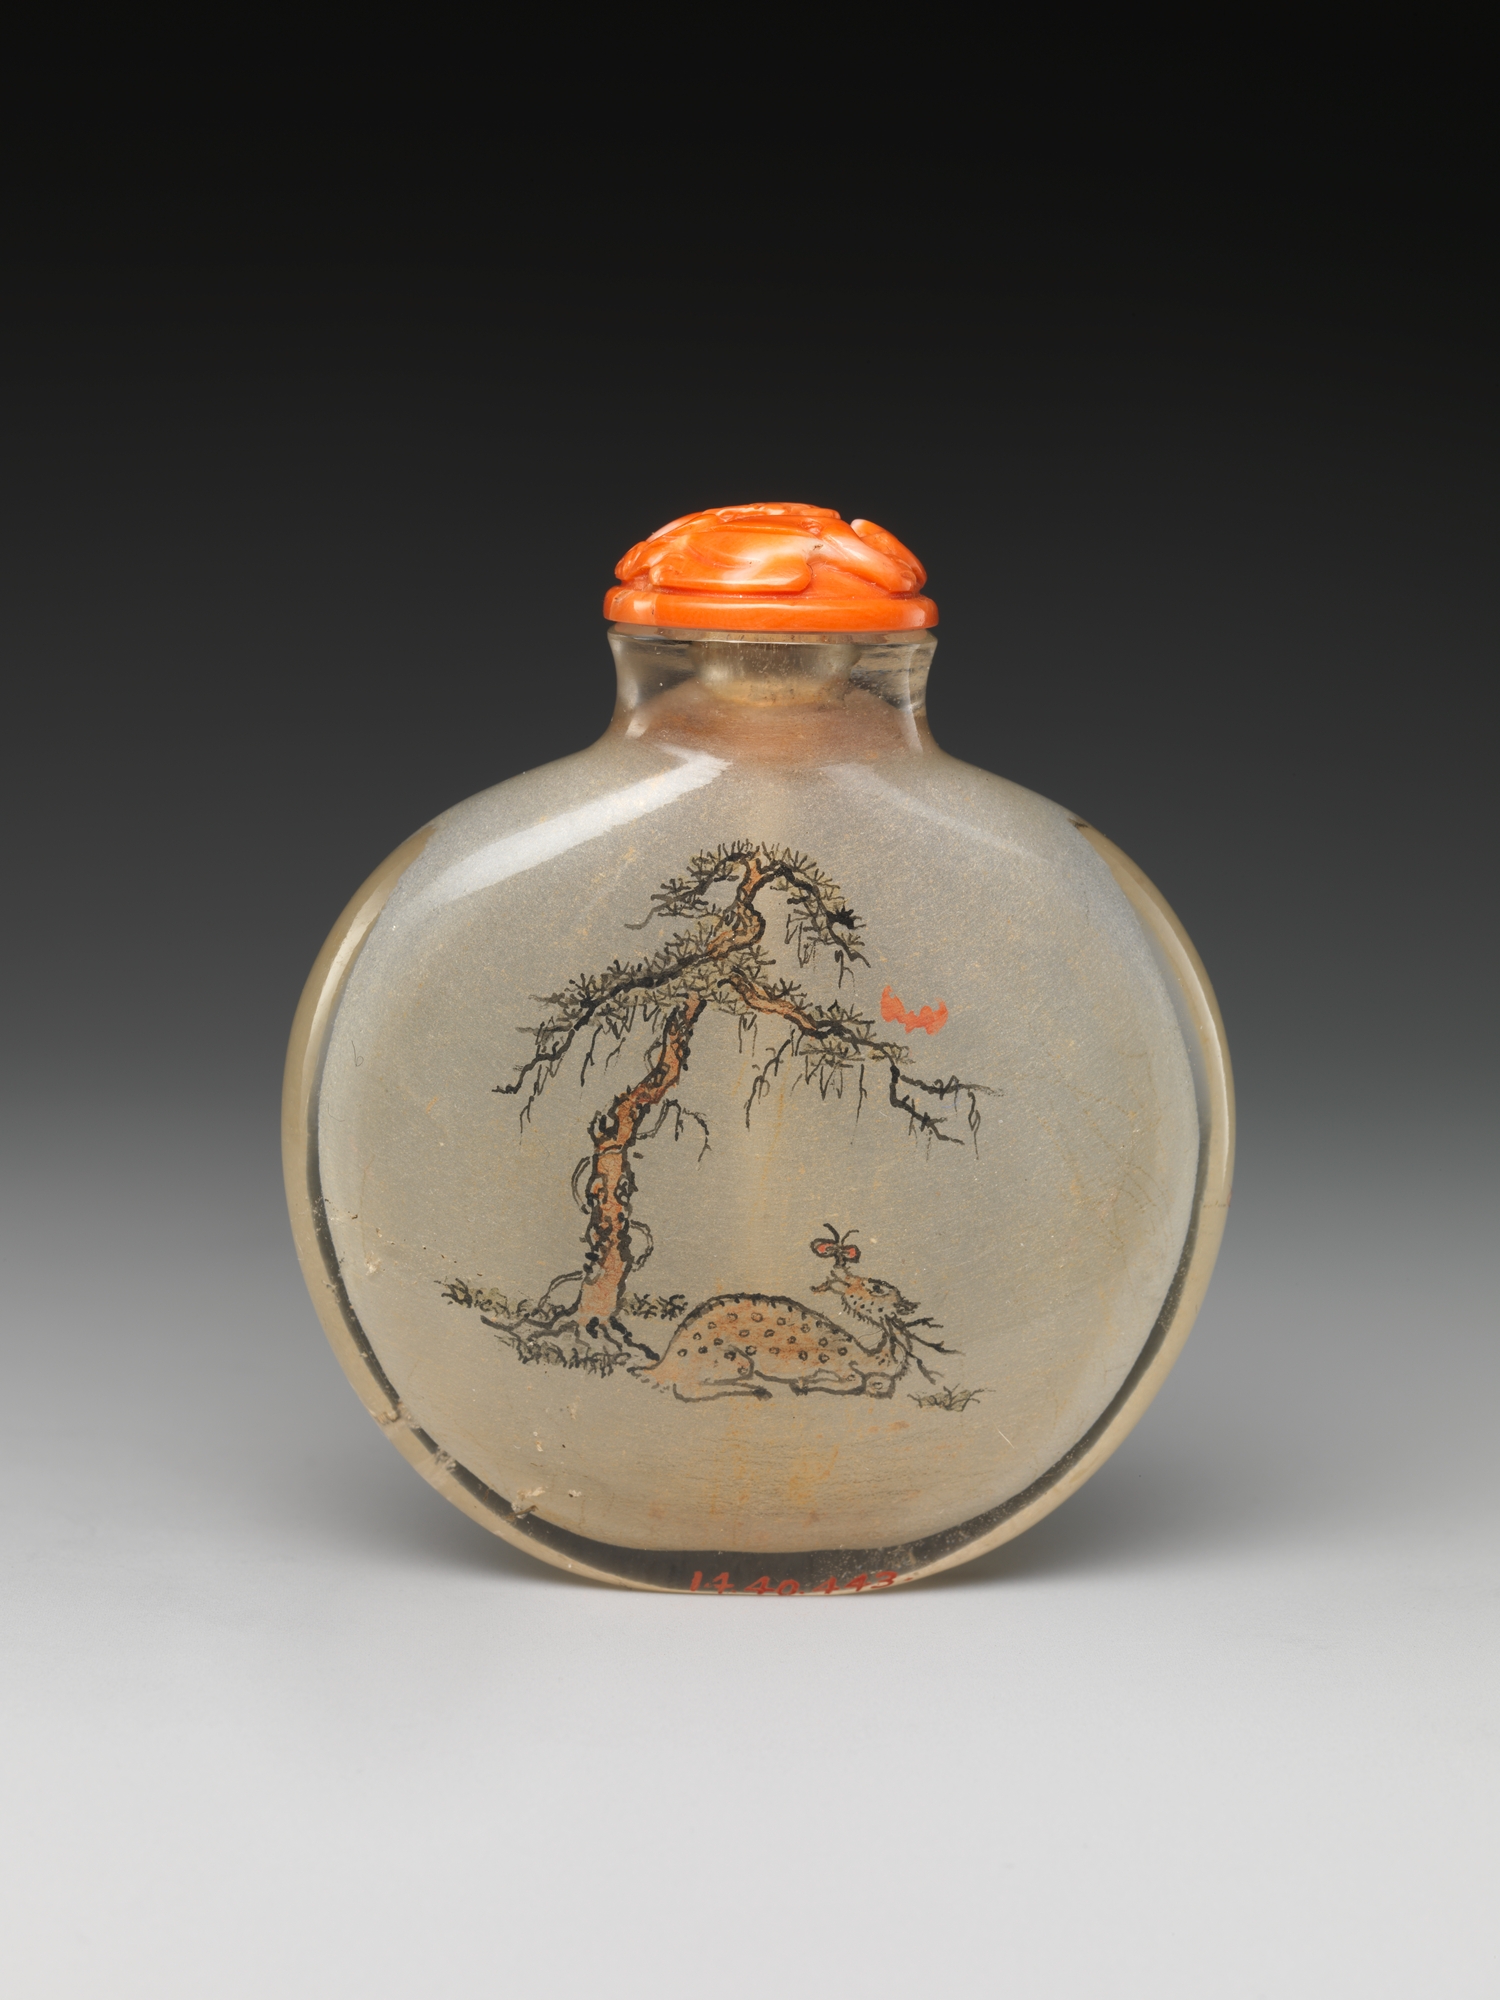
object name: snuff bottle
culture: chinese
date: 1869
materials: quartz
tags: deer,trees